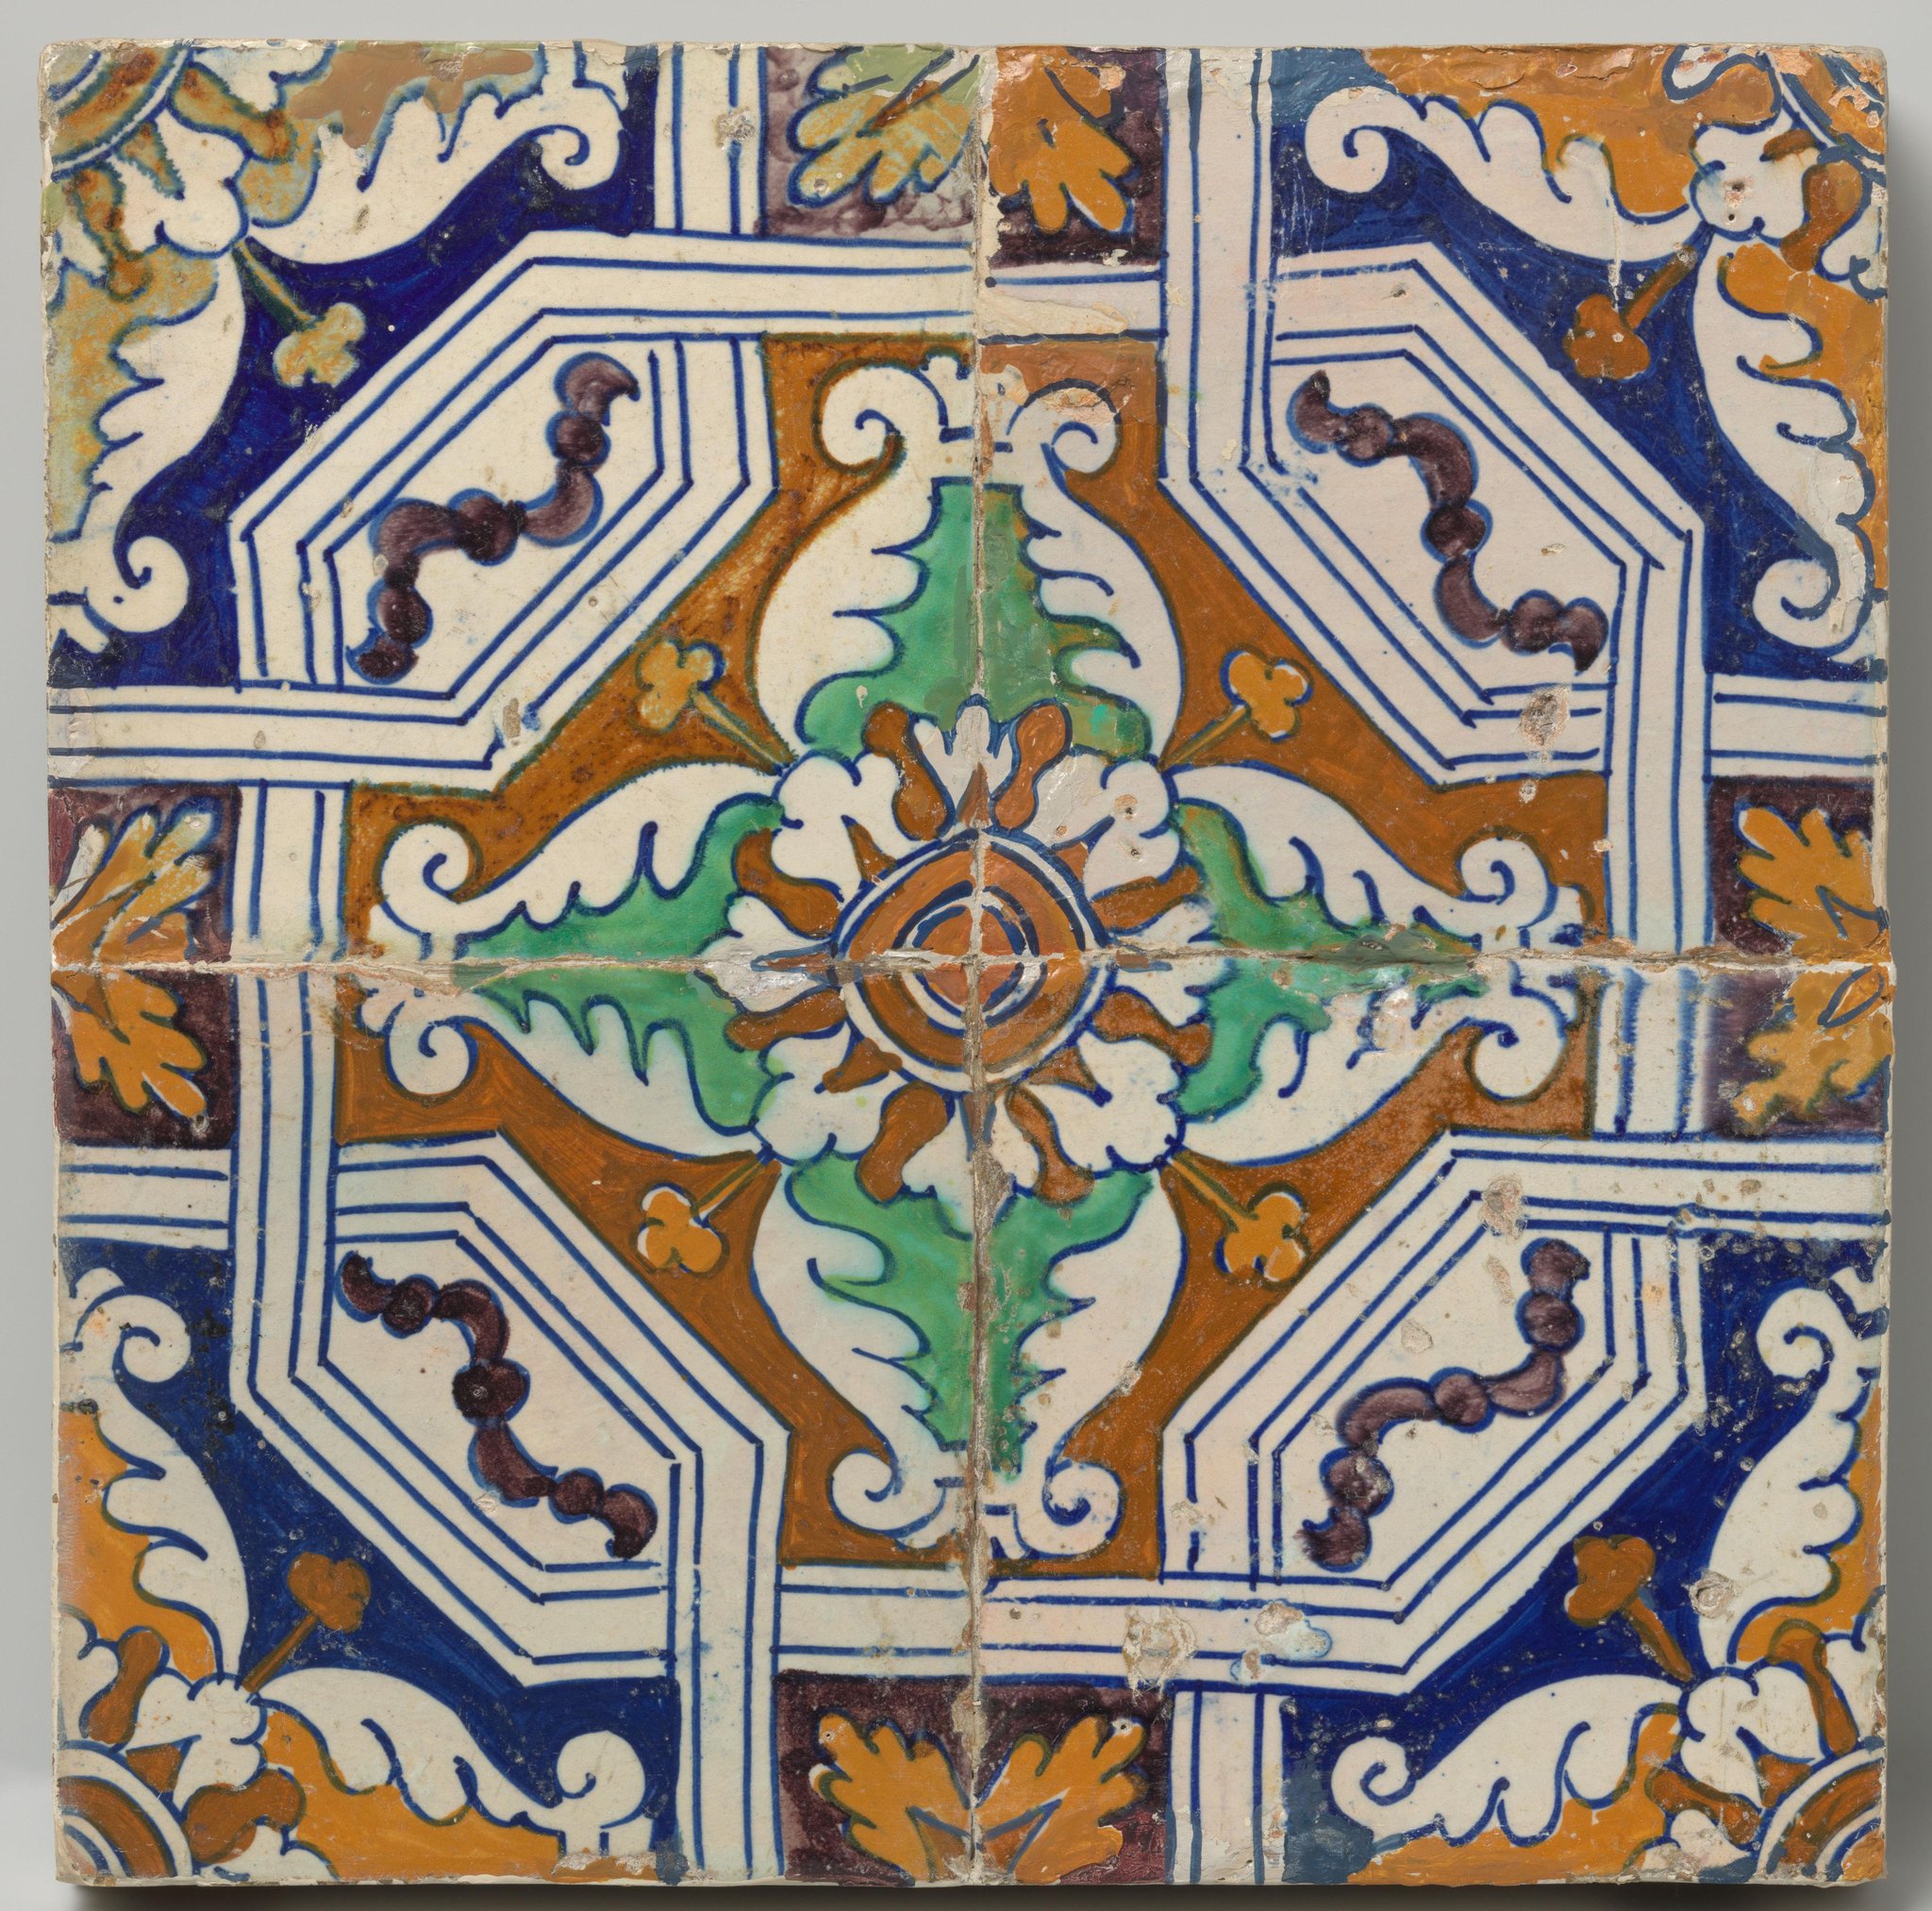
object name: architectural element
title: Bouwfragment met vier vloertegels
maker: Anonymous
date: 1560-1600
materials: earthenware, glaze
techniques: maiolica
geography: netherlands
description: Vier vloertegels (2 x 2) met een veelkleurige (blauw, oranje, oranjebruin, groen en paars) decoratie gevormd door de vier tegels bestaande uit een rozet omgeven door bladeren langs de vier hoofdassen binnen een vierkant met afgeschuinde hoeken.